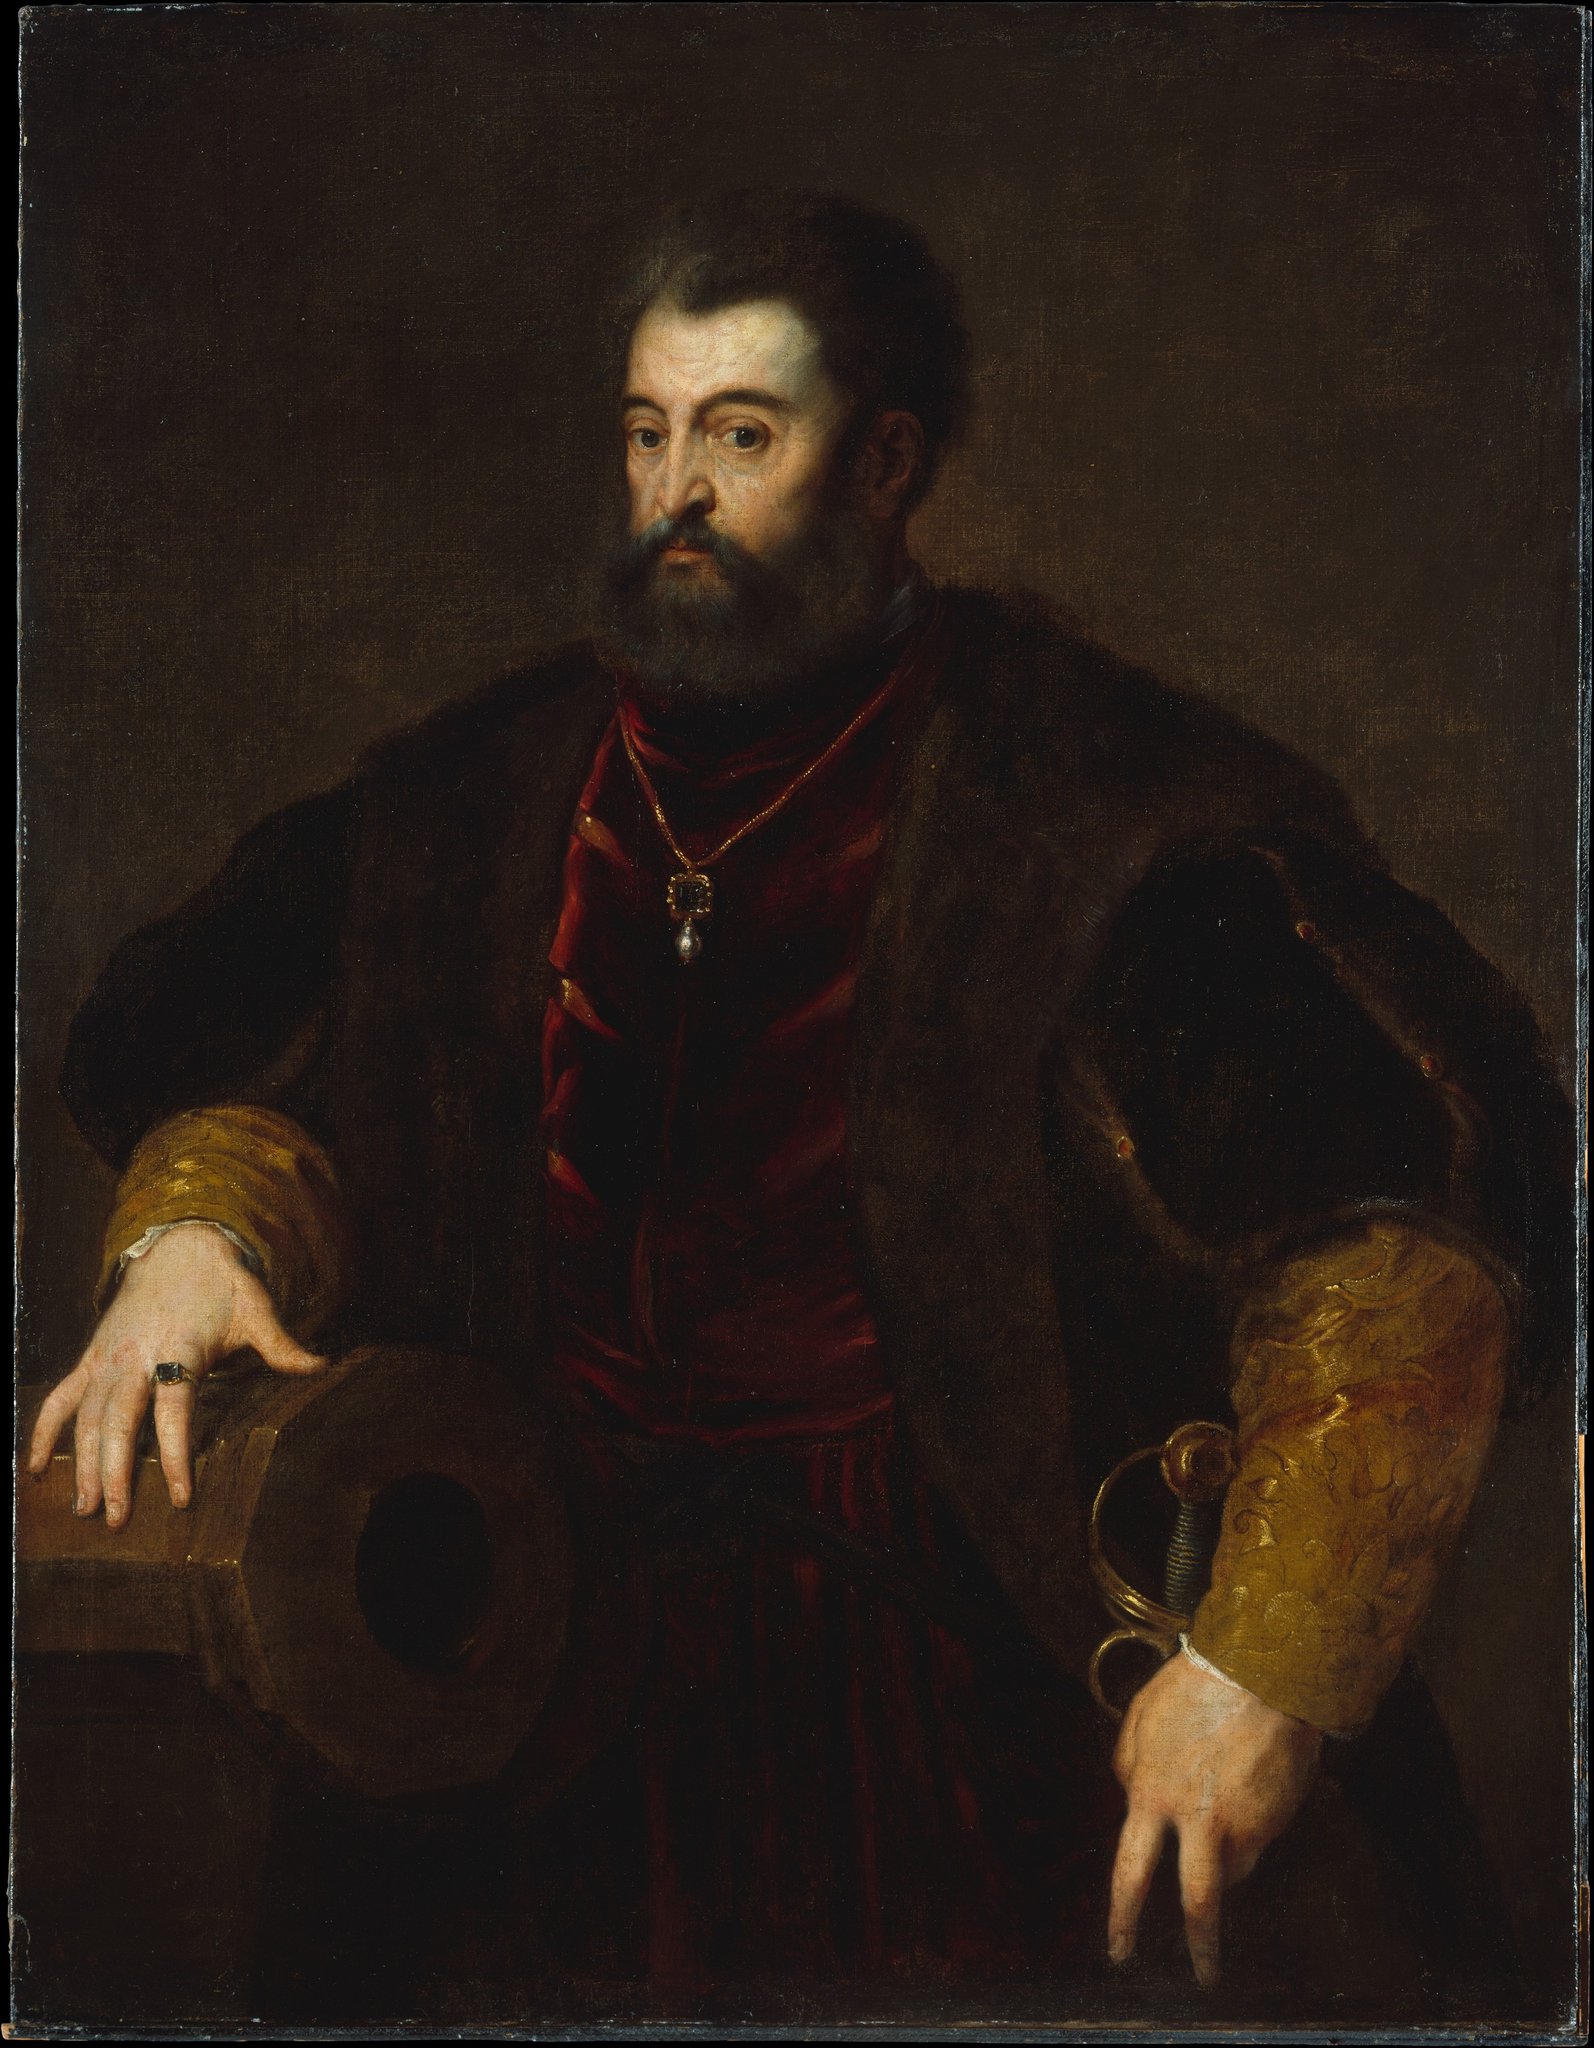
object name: painting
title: Alfonso d'Este (1486–1534), Duke of Ferrara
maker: titian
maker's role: artist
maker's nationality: italian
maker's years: 1485-1576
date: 1570-1629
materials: canvas, oil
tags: men,portraits